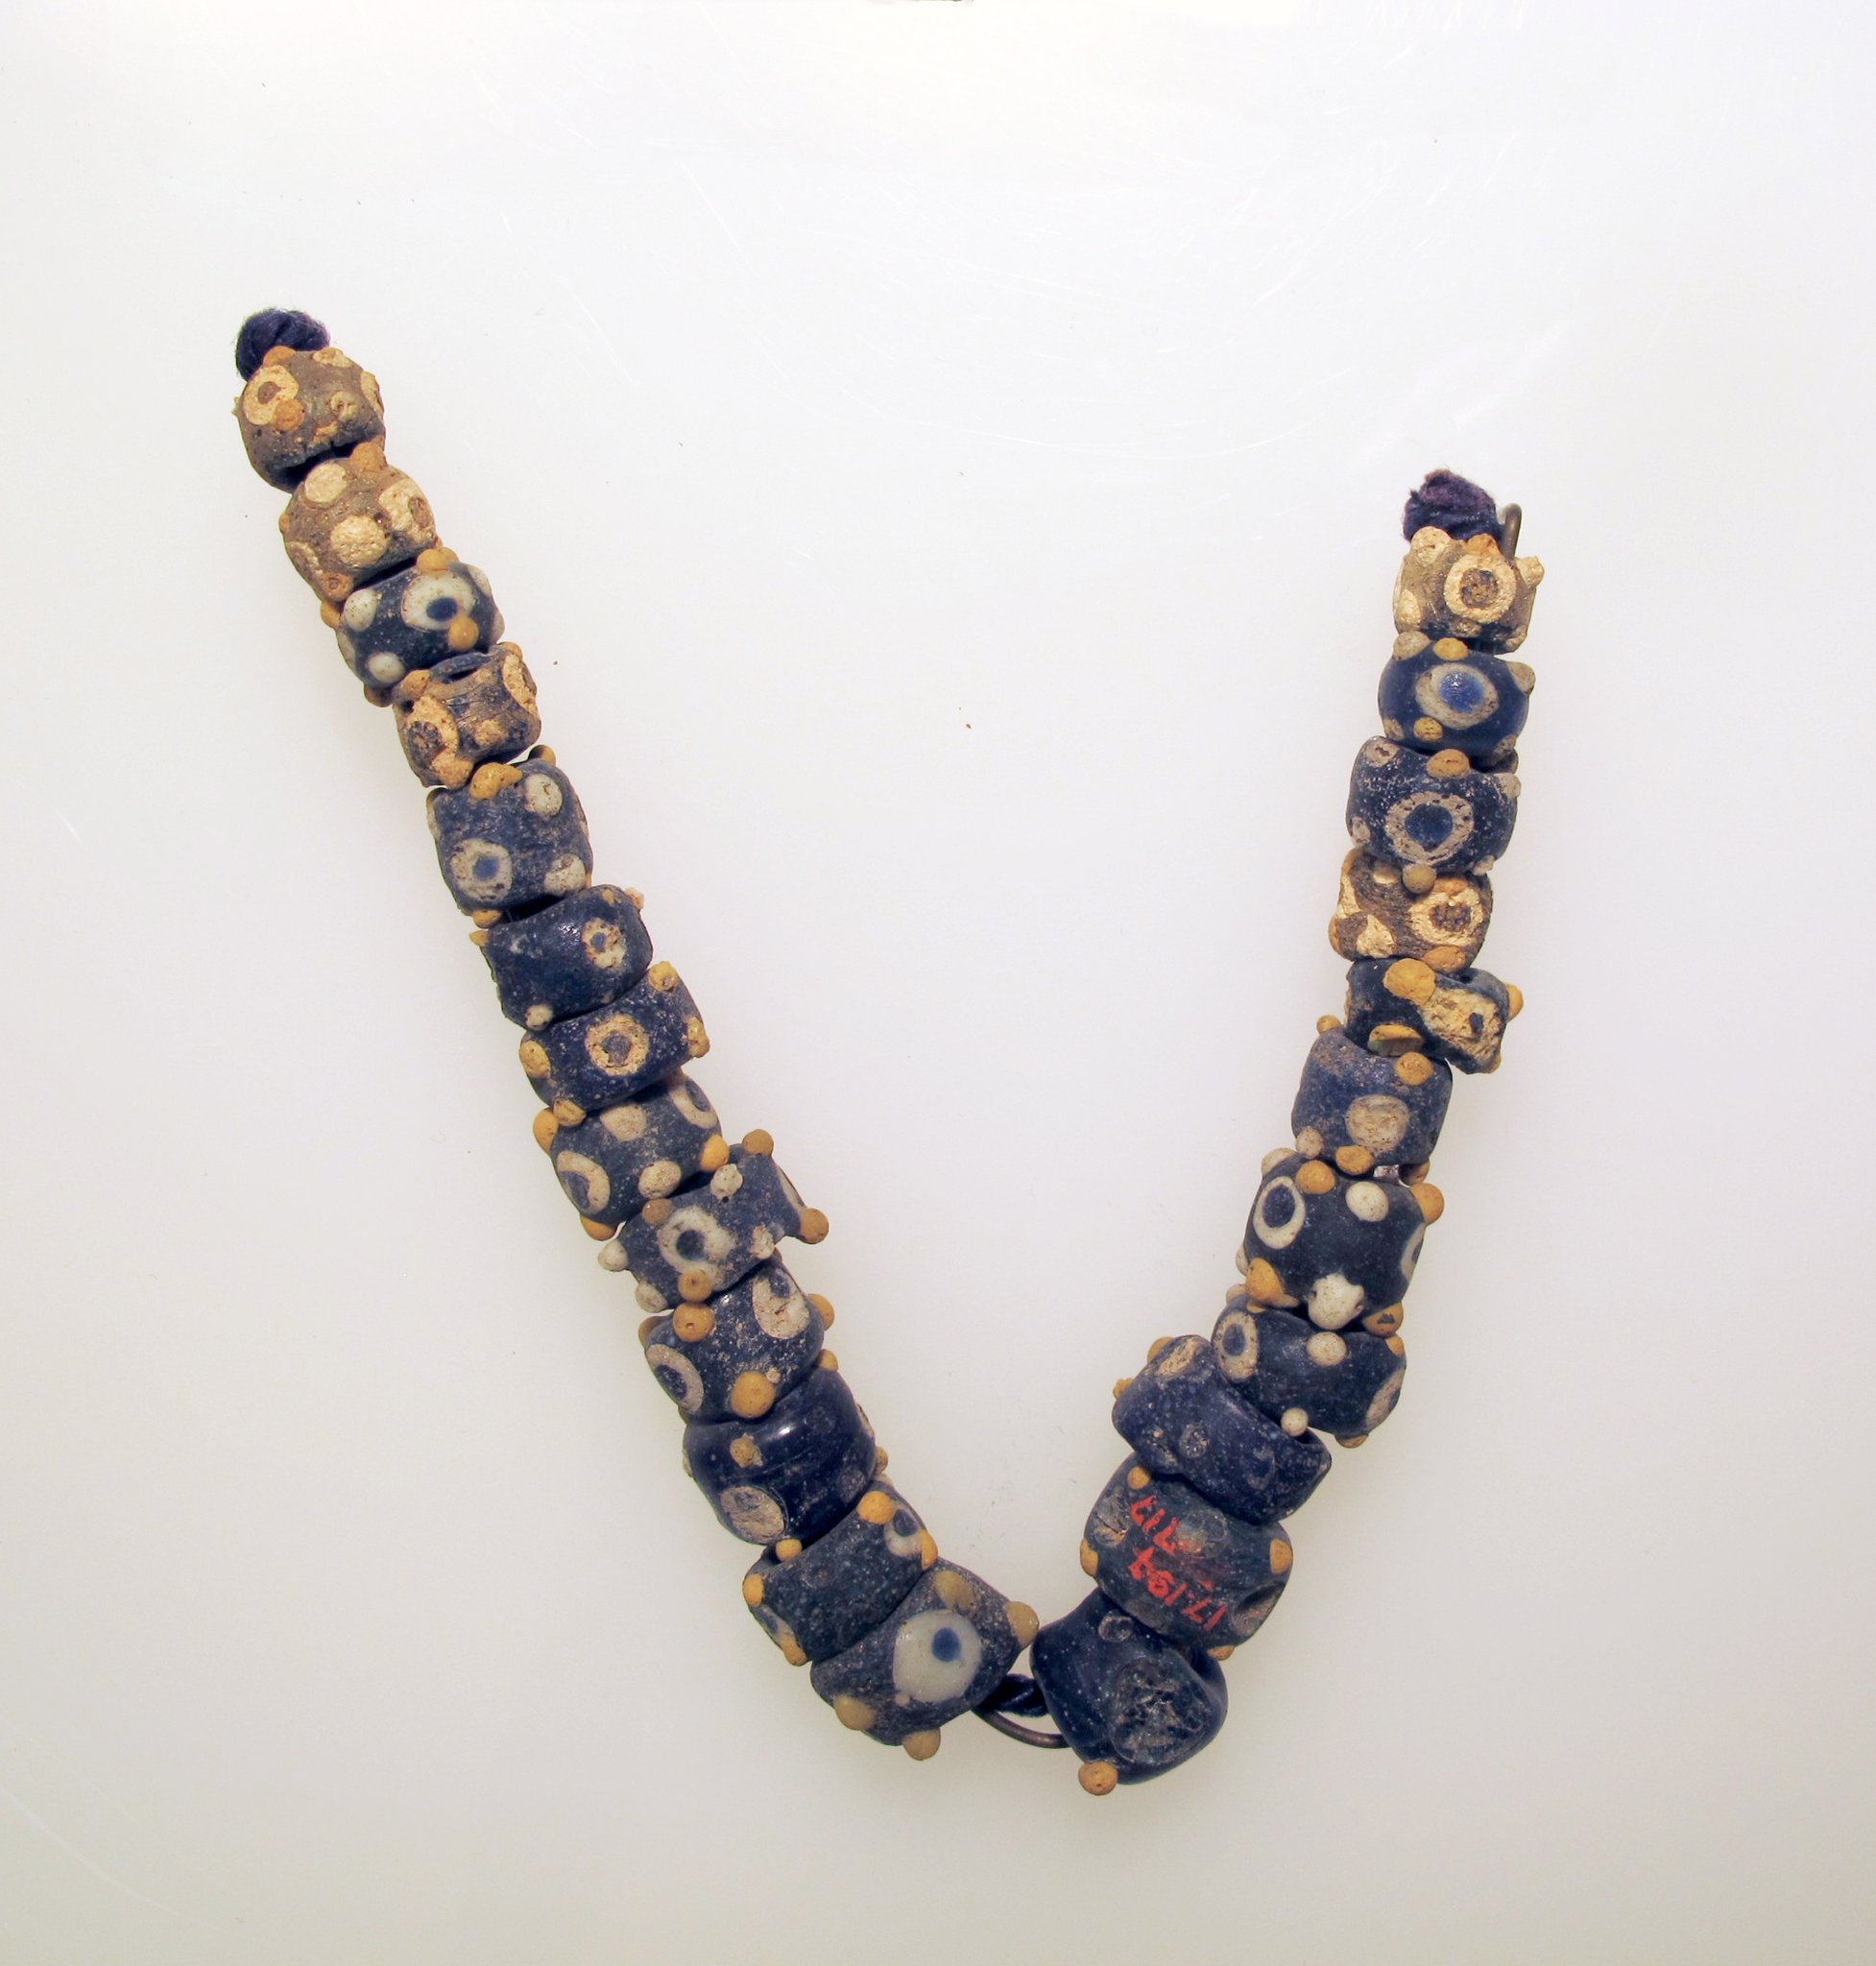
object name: bead, 24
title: Glass eye beads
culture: carthaginian or phoenician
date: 400-201 BCE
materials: glass